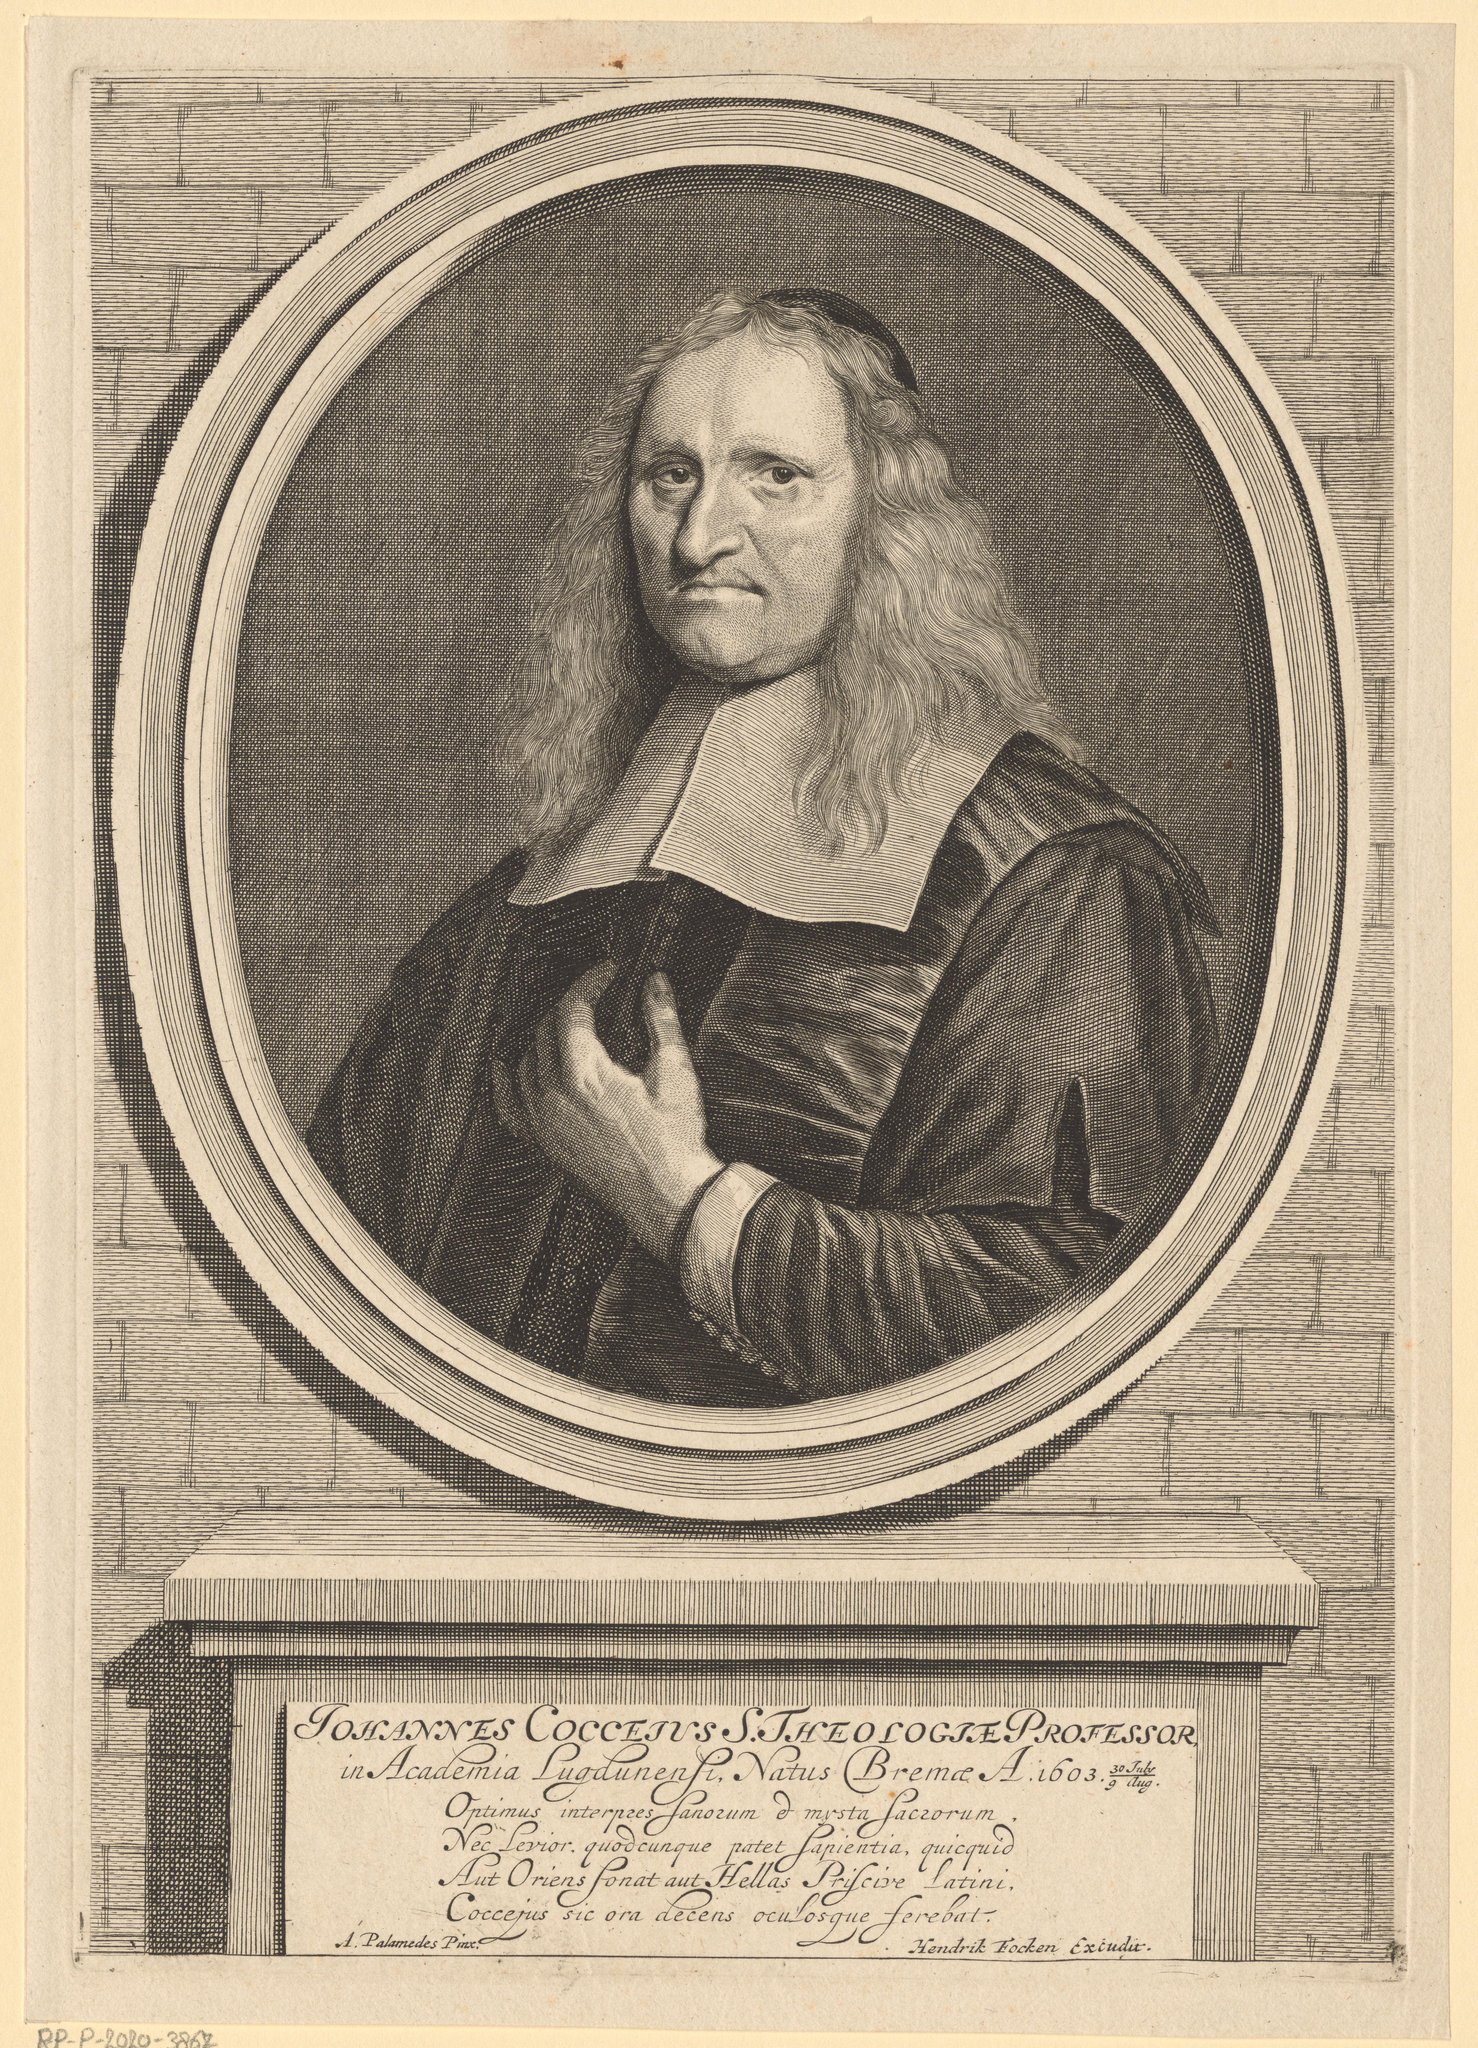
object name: print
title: Portret van Johannes Cocceius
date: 1665-1689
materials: paper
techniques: engraving, etching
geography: amsterdam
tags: historical persons